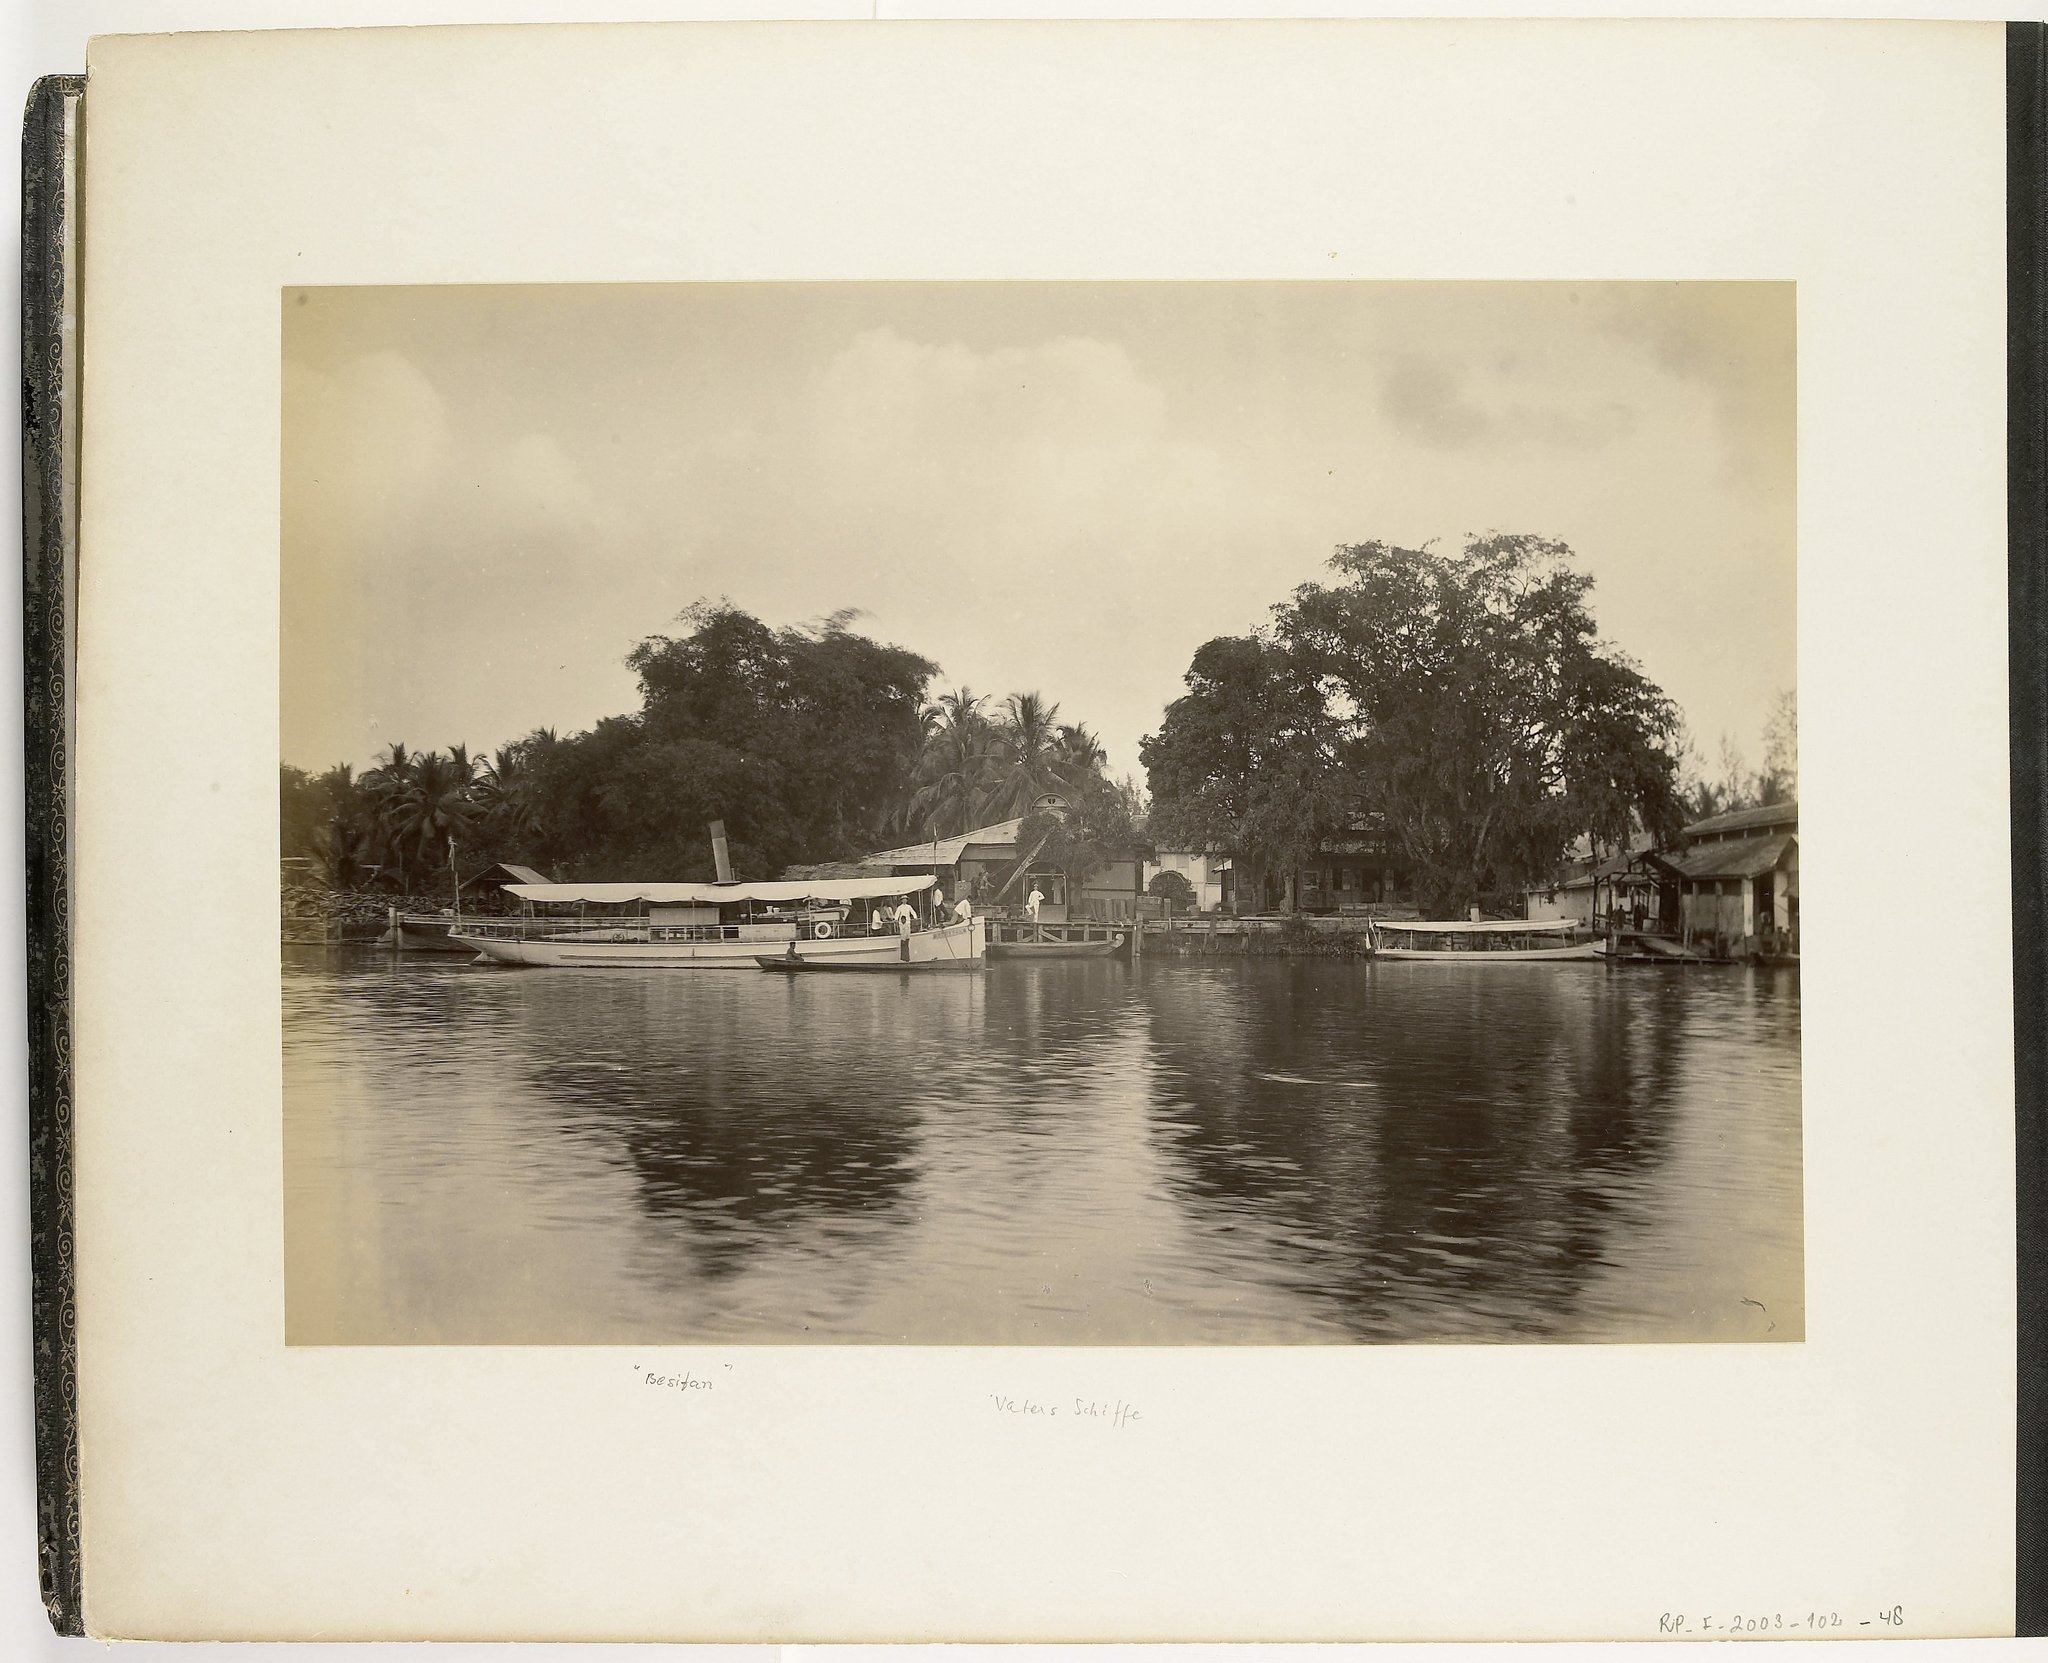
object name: photograph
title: Sandels boot Besitan, Tandjong Poera, Sumatra (P. Sandel's Schiffe Besitan, Tandjong Poera)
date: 1898-1900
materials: photographic support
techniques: albumen print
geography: tandjong poera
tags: tandjong poera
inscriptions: inscription: ‘"Besitan" Vaters Schiffe’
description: Paul Sandels stoombootje genaamd Besitan (of Bessitan) liggend aan de kade van Tandjong Poera op Sumatra. Onderdeel van het Sumatra fotoalbum van Paul en Lucie Sandel uit 1900.